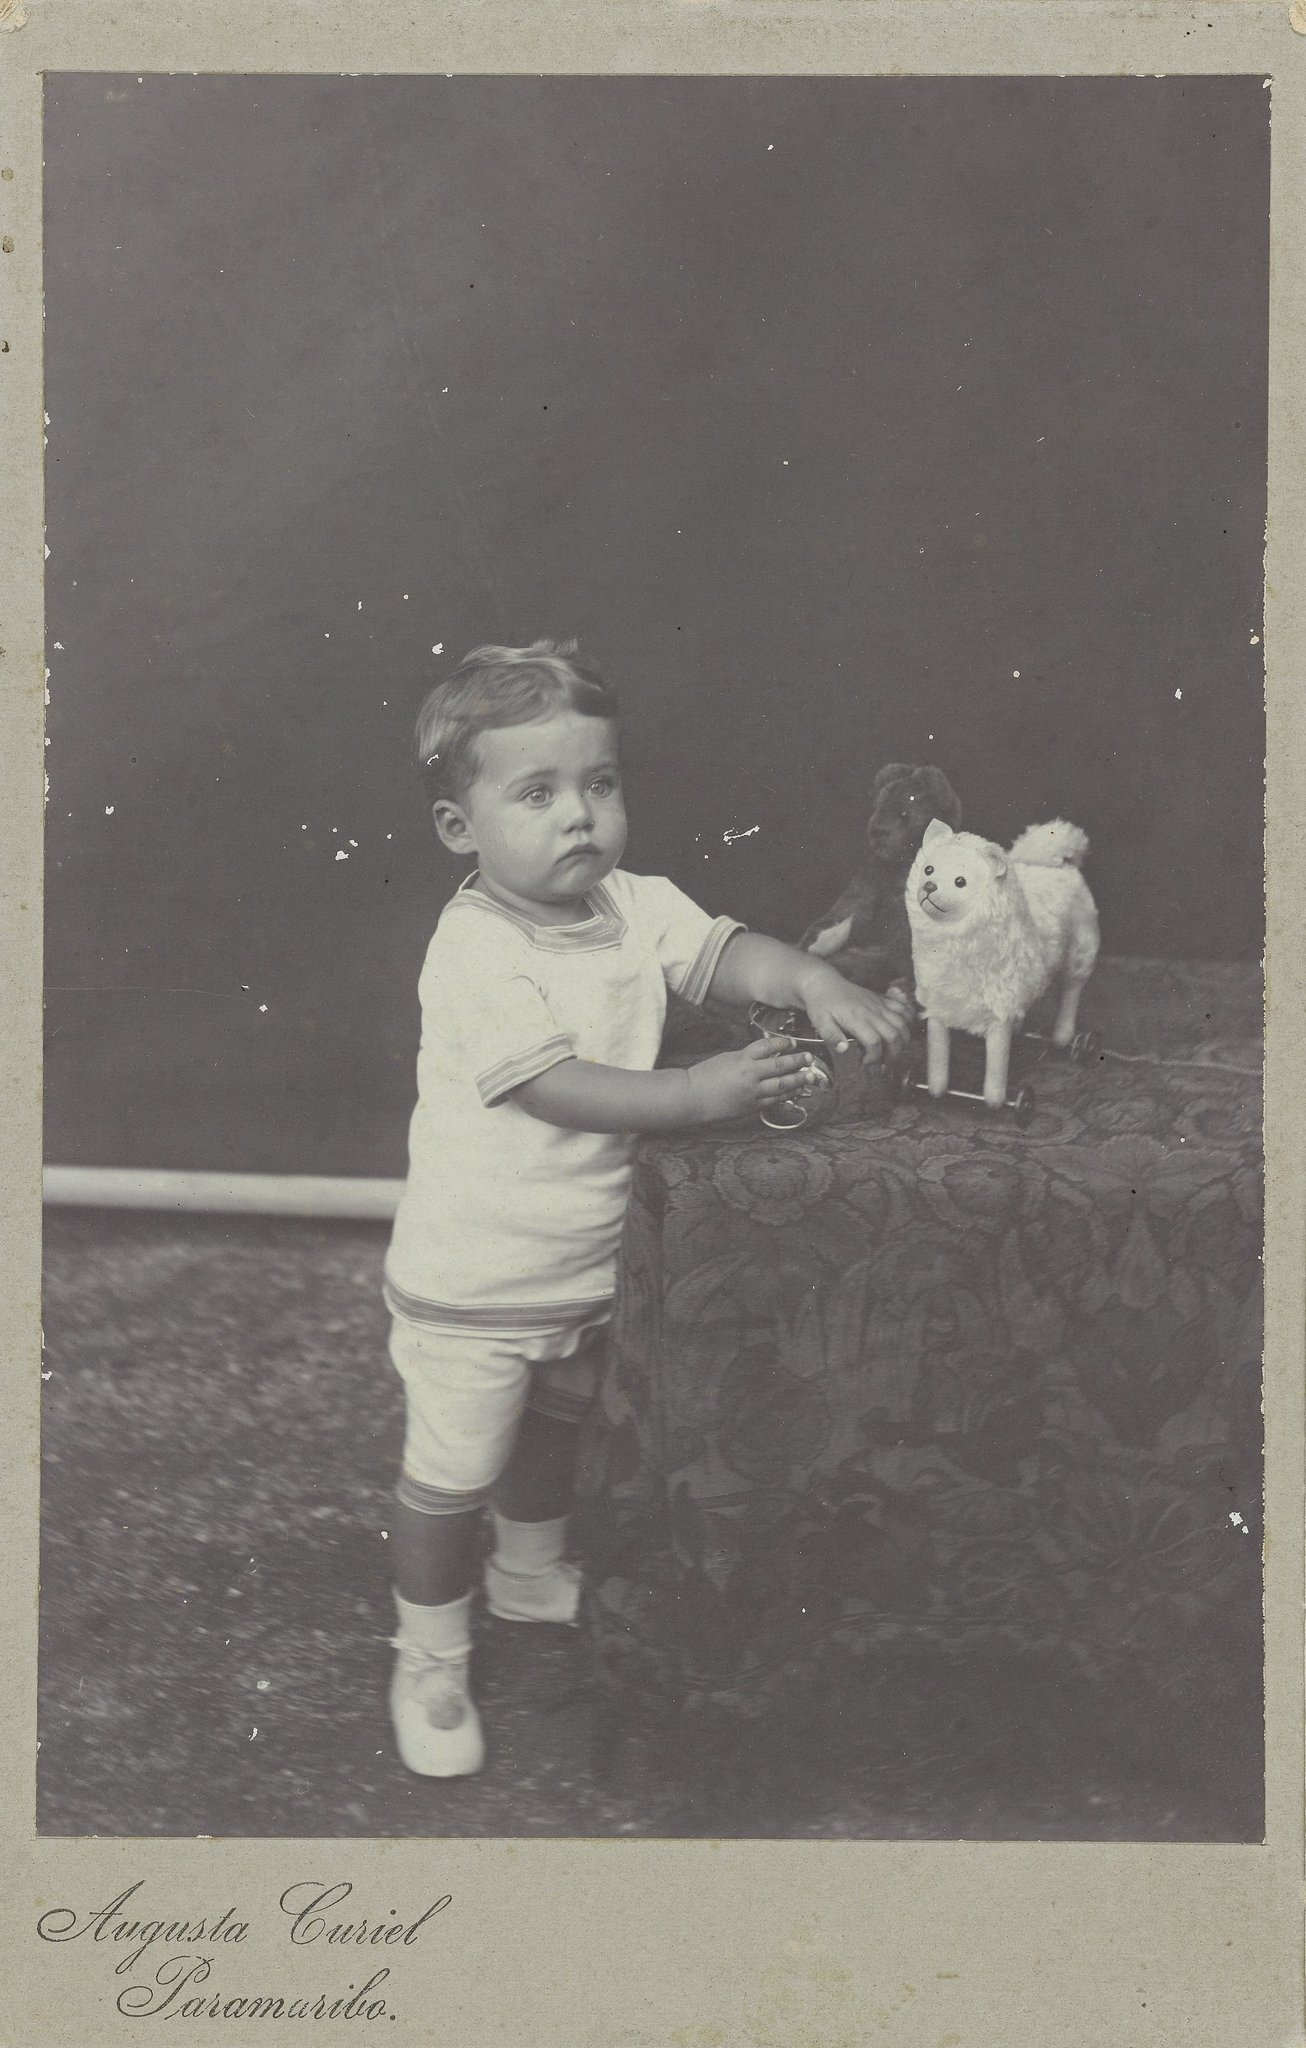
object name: cabinet photograph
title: Theodoor Brouwers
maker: augusta curiel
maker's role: fotograaf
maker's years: 1873-1937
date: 1911-1915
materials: photographic support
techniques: photography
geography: paramaribo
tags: theodoor brouwers, suriname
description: Portret van een jongetje, staande naast een tafel waarop een speelgoedhondje.